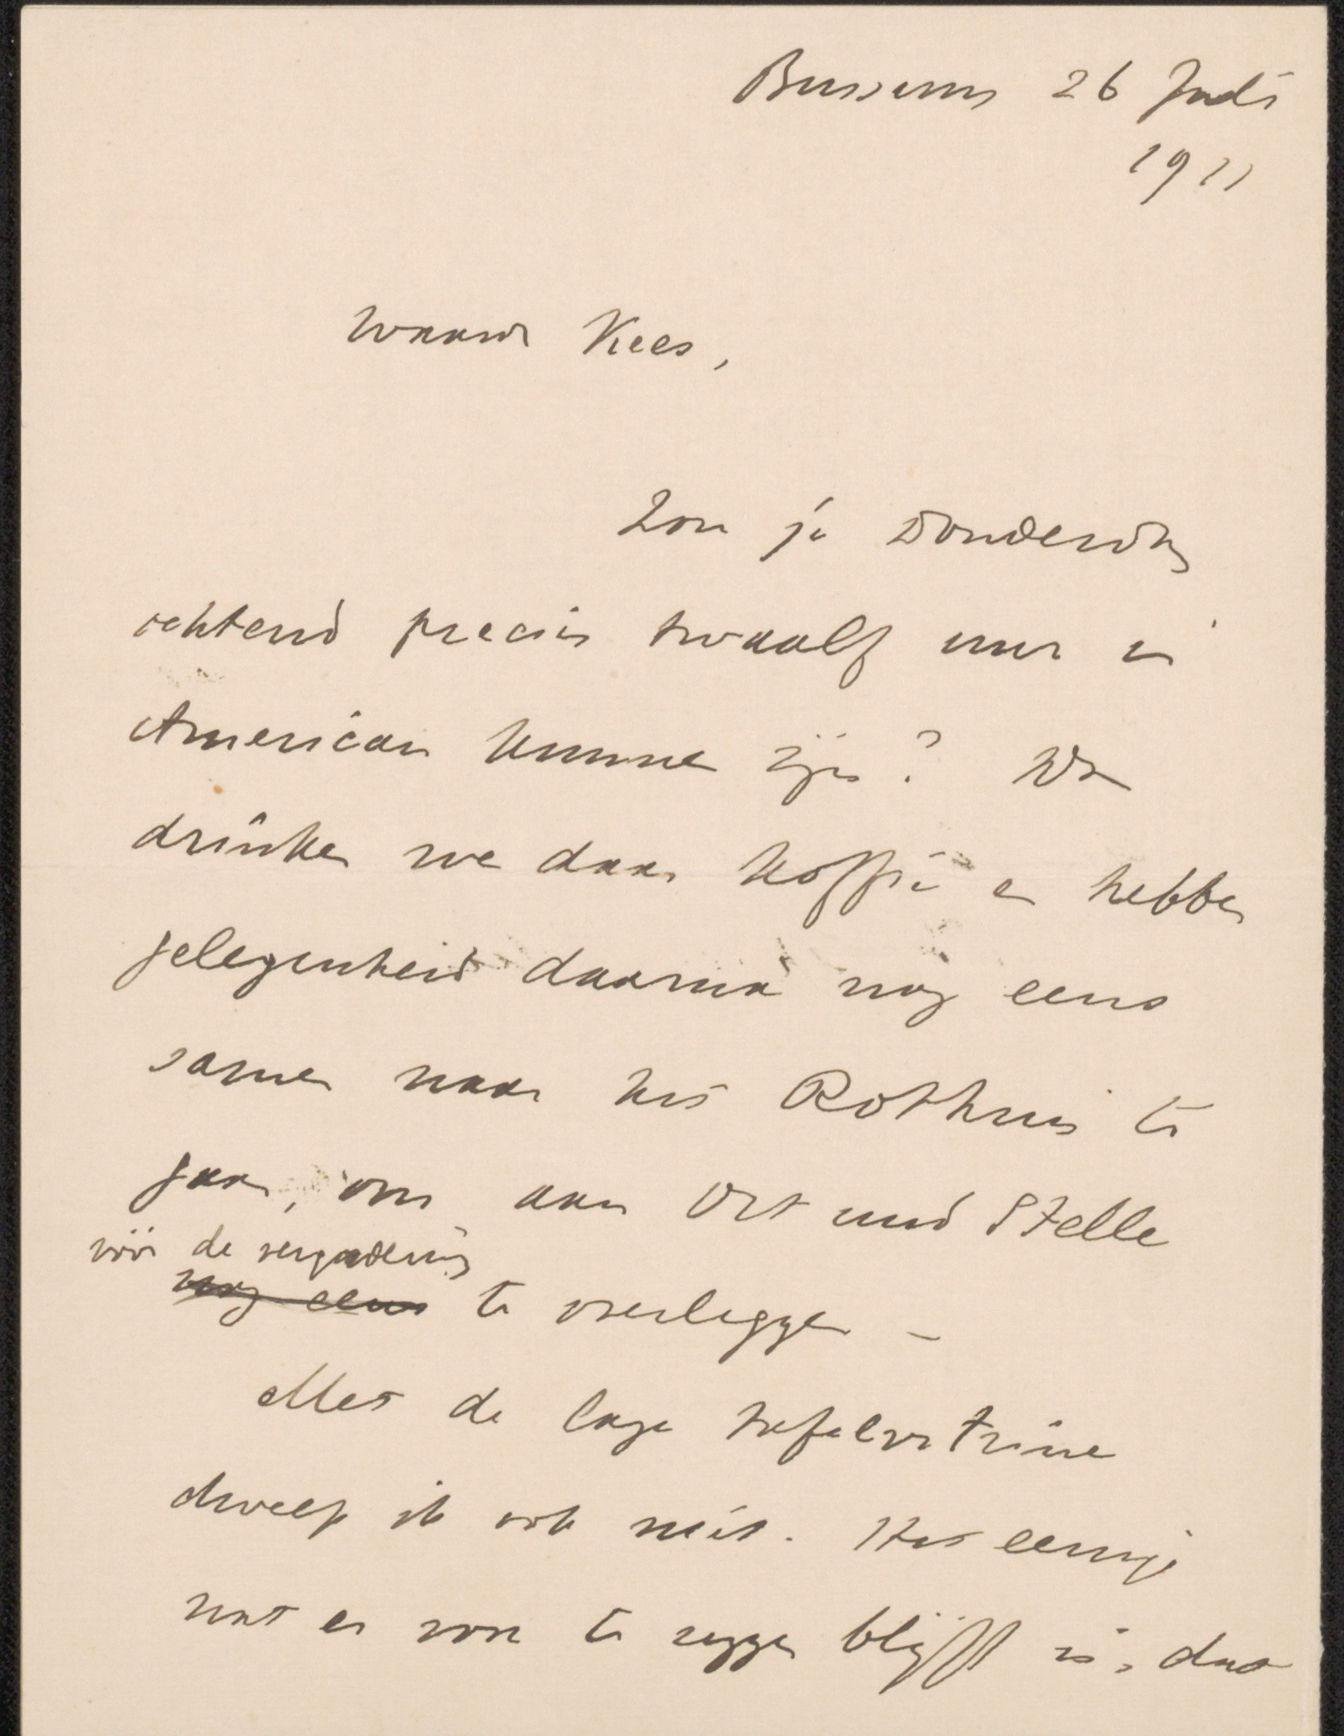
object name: letter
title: Brief aan Cornelis Gerdus 't Hooft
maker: jan veth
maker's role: designer, draughtsman, painter, print maker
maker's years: 1864-1925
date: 1911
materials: ink, paper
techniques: pen, writing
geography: bussum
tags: cornelis gerardus 't hooft, exhibition ~ art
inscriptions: collector's mark: ‘RPK’, watermark